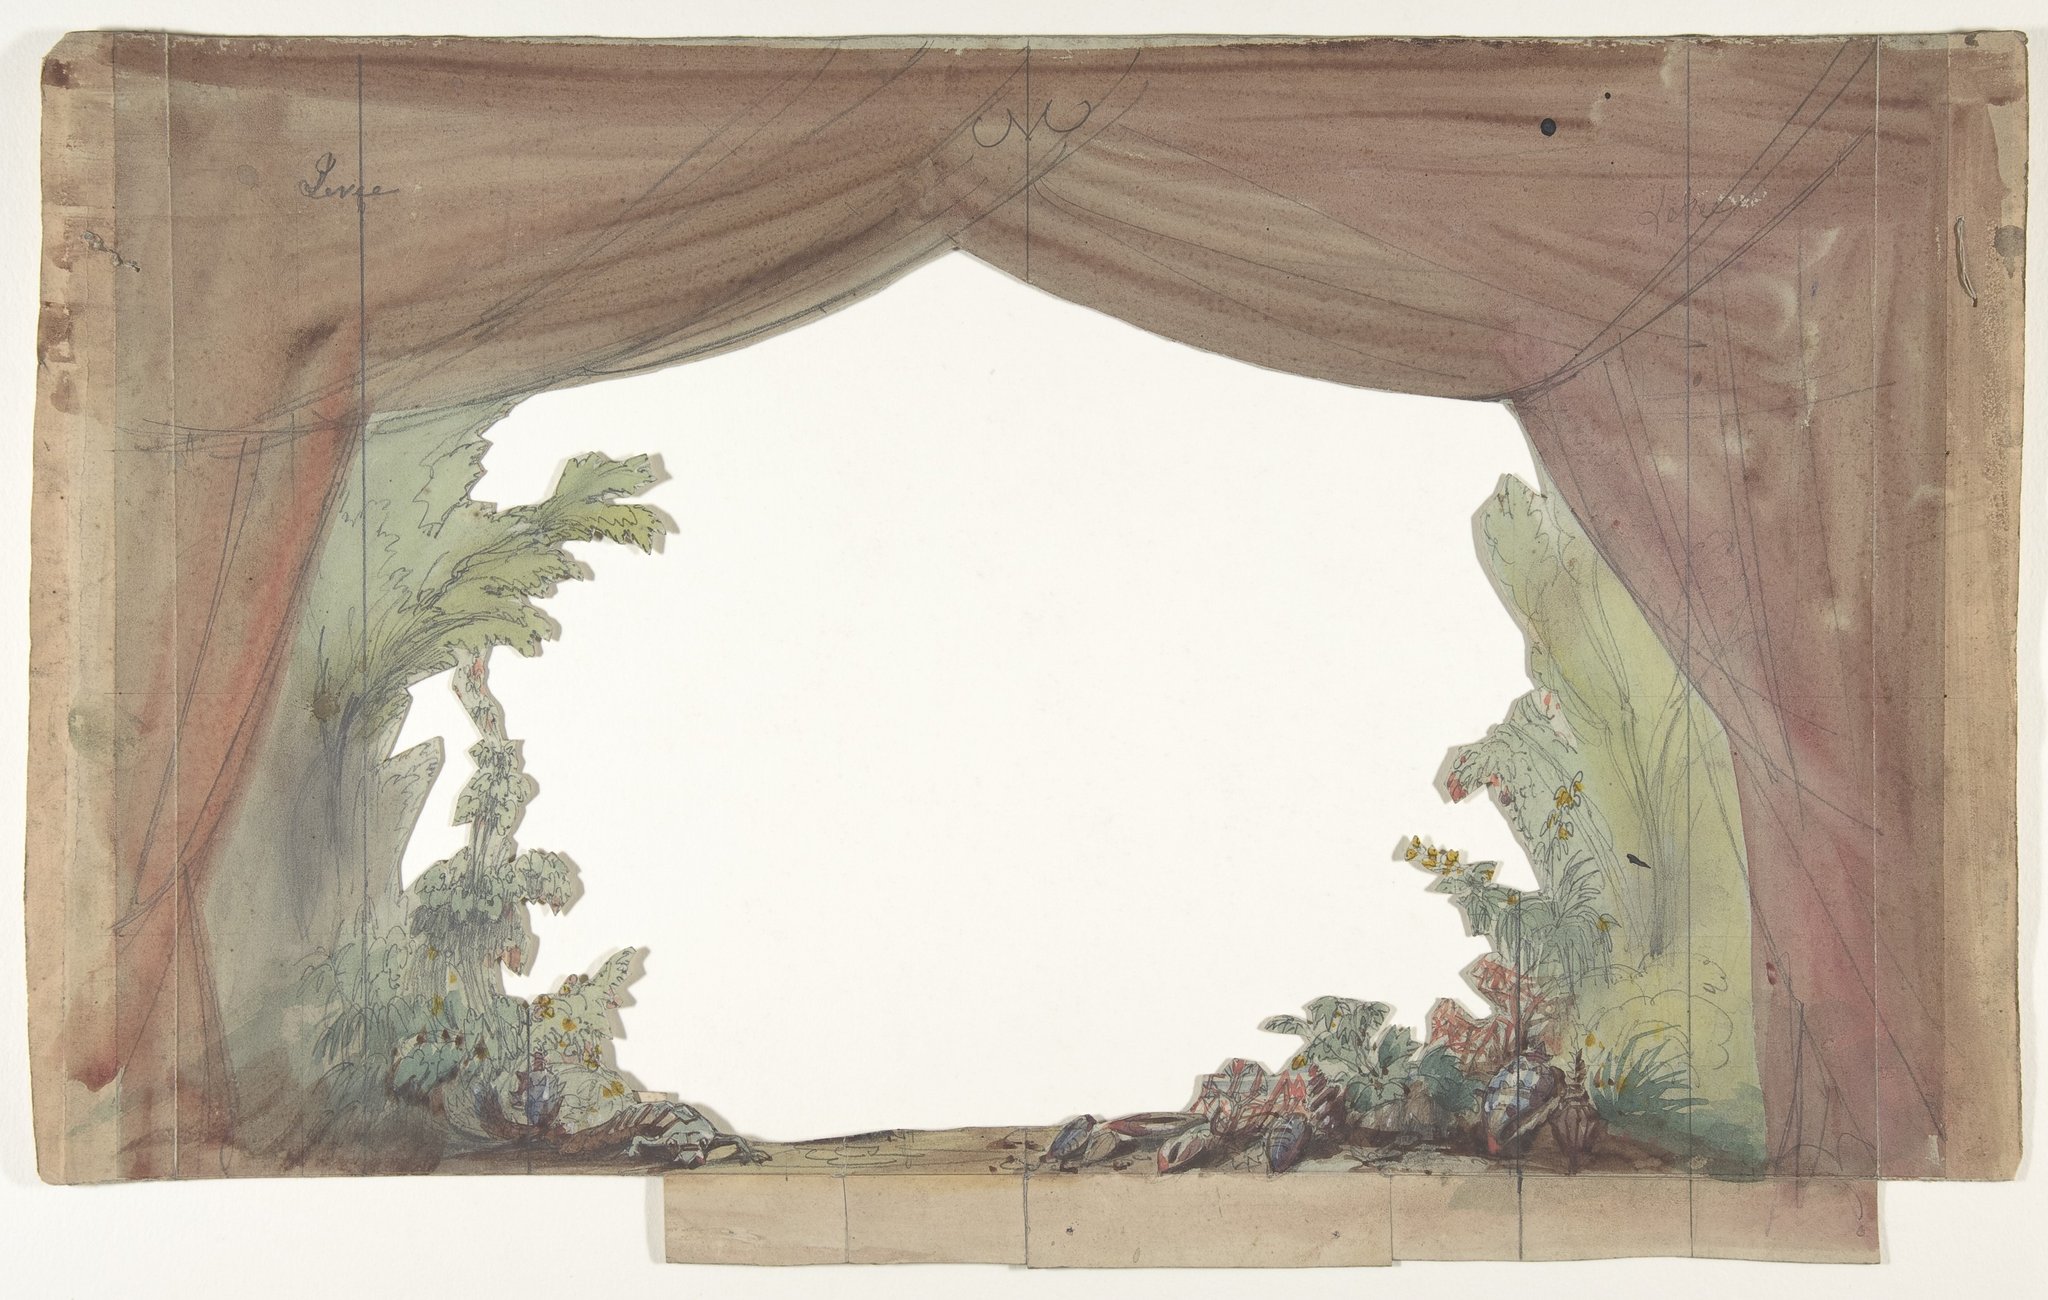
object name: drawing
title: Design for a Stage Set at the Opéra, Paris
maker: eugène cicéri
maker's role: artist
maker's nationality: french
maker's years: 1813-1890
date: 1830-1890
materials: graphite, watercolor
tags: stage design